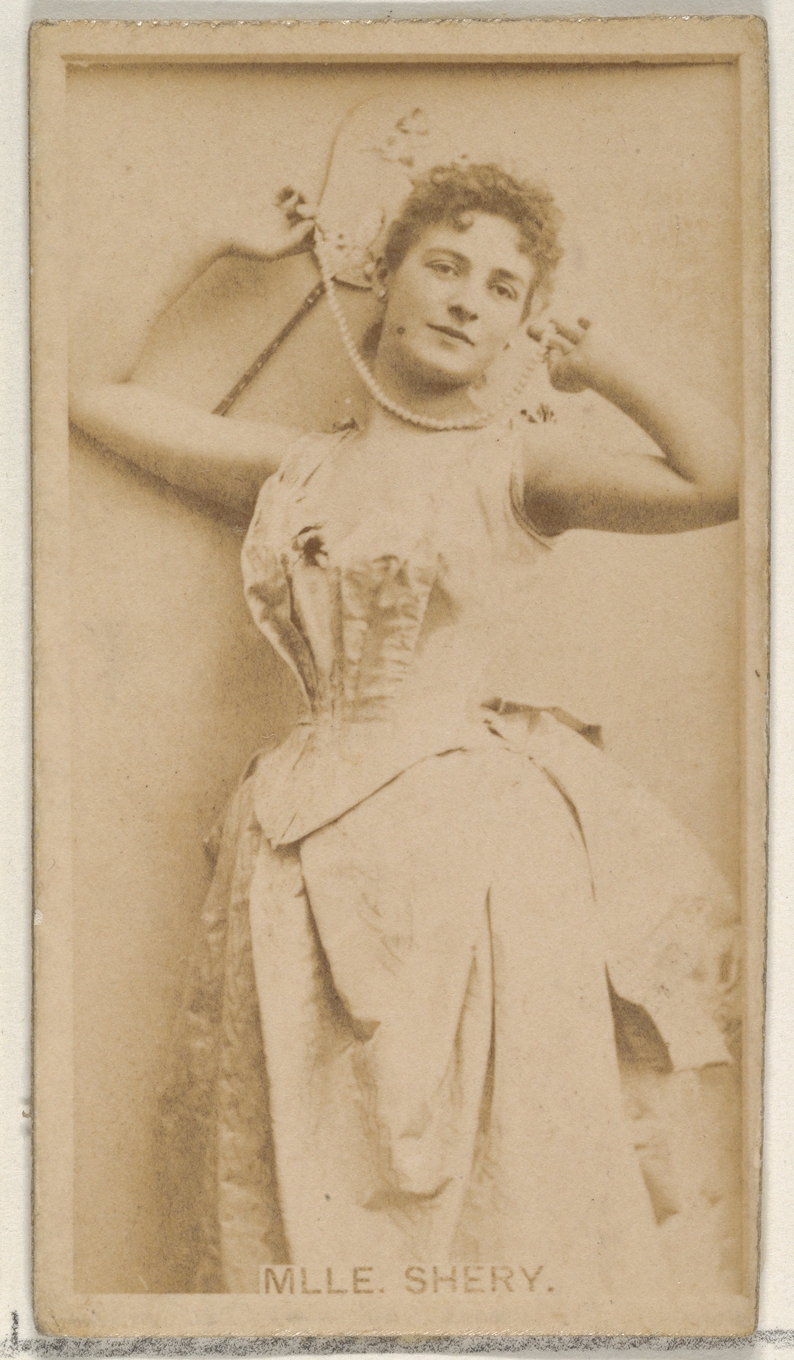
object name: photograph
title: Mlle. Shery, from the Actors and Actresses series (N45, Type 8) for Virginia Brights Cigarettes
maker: allen & ginter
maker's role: publisher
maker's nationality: american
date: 1888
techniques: albumen silver print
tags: portraits,women,actresses